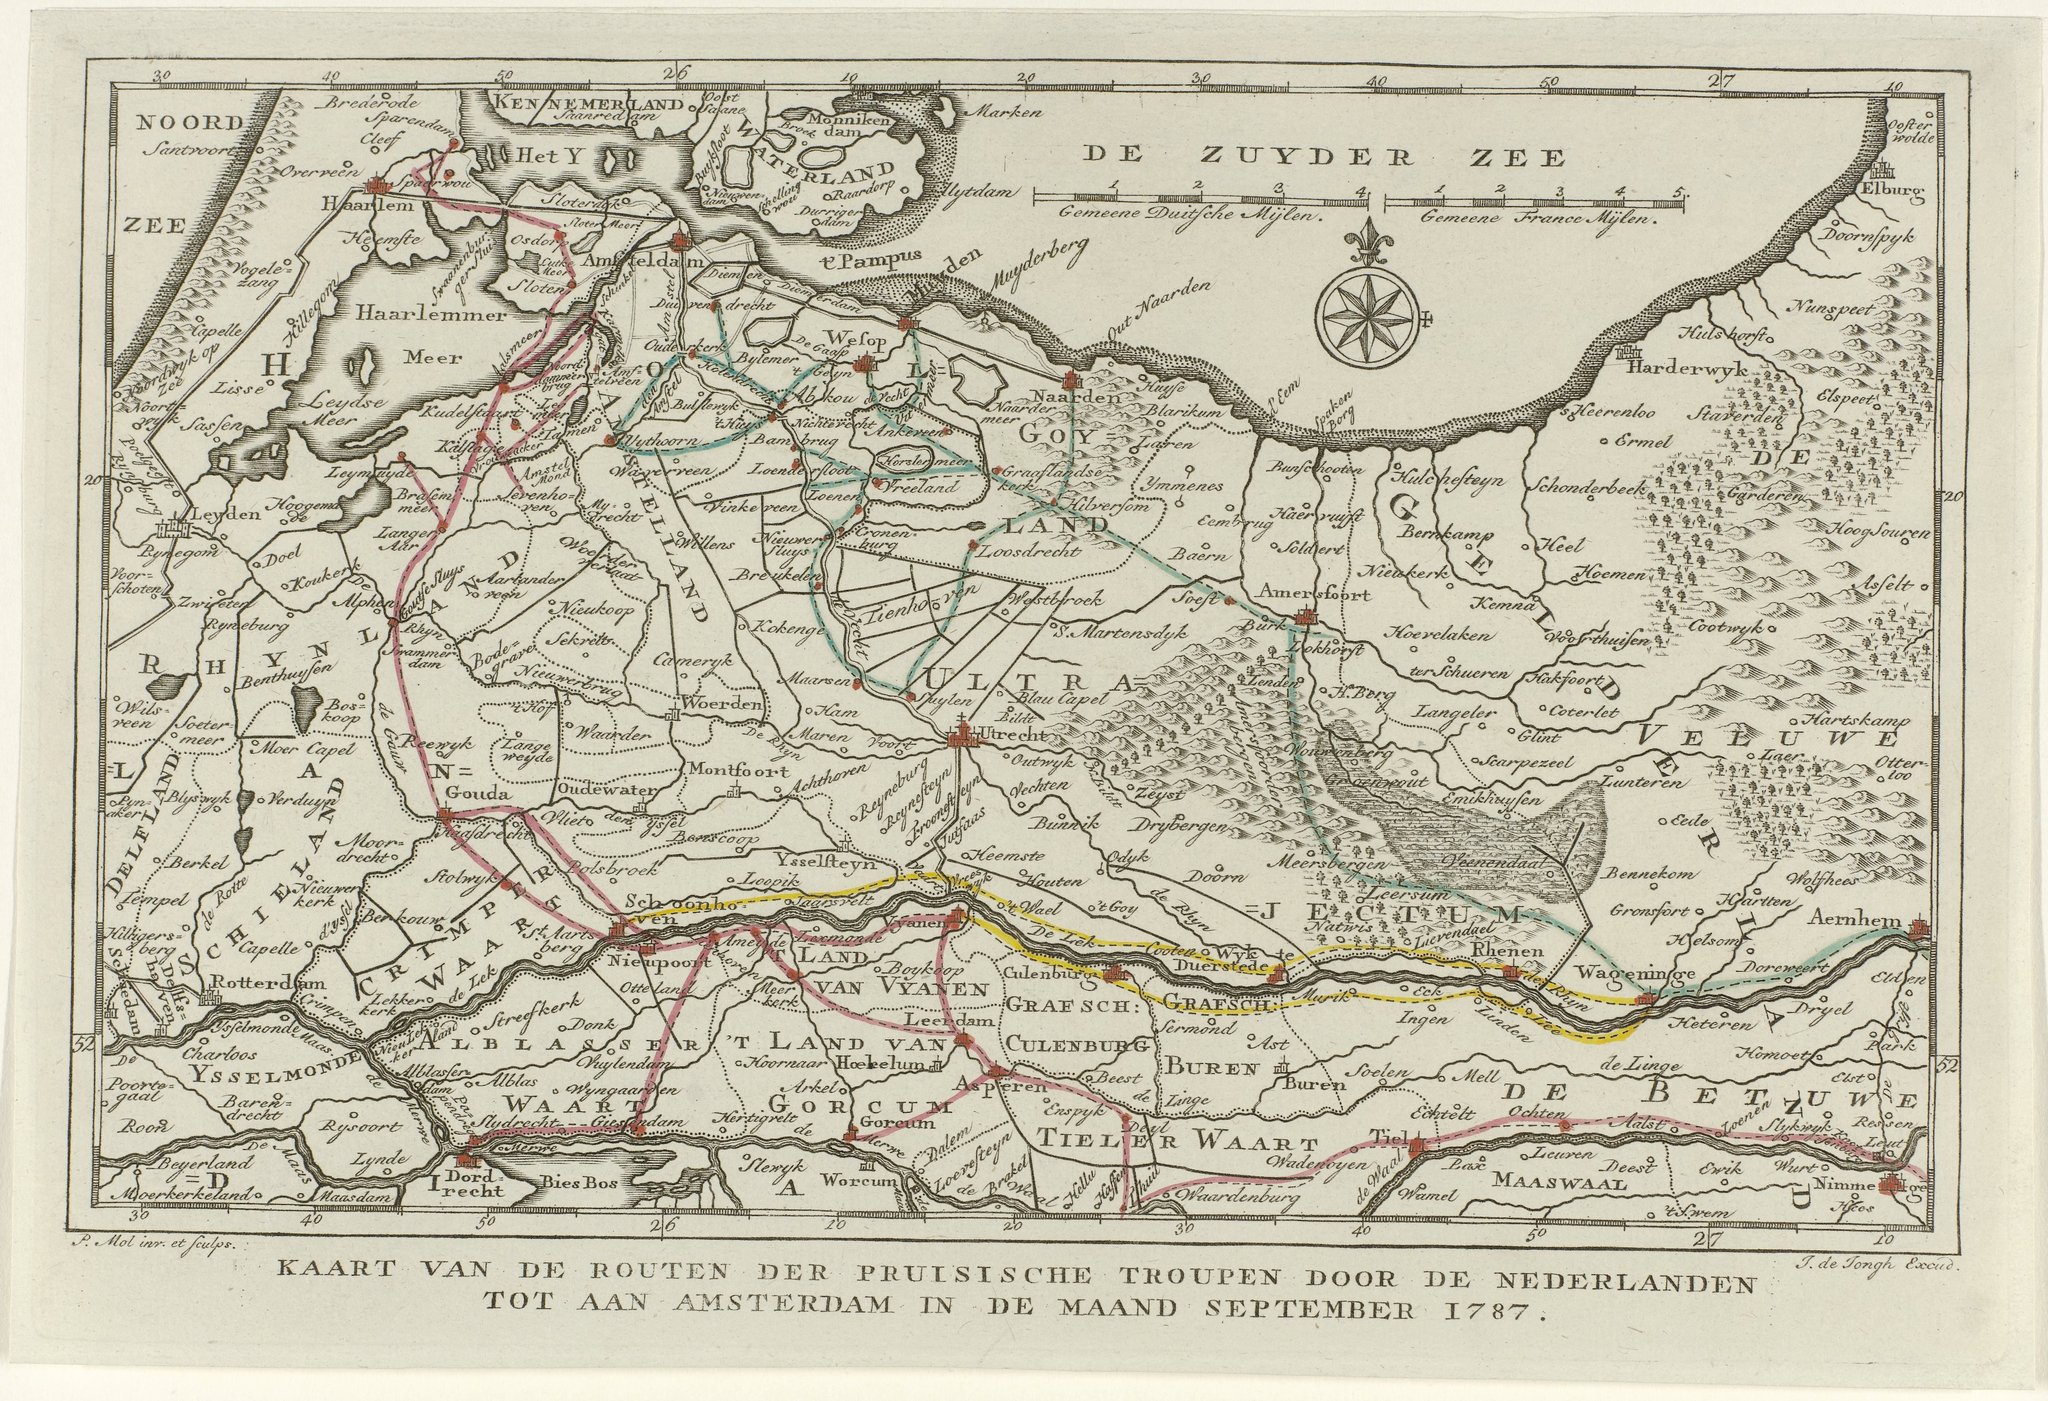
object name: print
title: Kaart van de routen der Pruisische troupen door de Nederlanden tot aan Amsterdam in de maand september 1787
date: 1787-1788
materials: paper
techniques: engraving, etching, hand coloring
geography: amsterdam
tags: maps of separate countries or regions, gelderland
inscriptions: collector's mark: Lugt 2228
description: Marskaart waarop de routes zijn aangegeven die de Pruisische troepen gevolgd hebben onderweg naar Amsterdam, tijdens de interventie in de Nederlanden in september 1787.